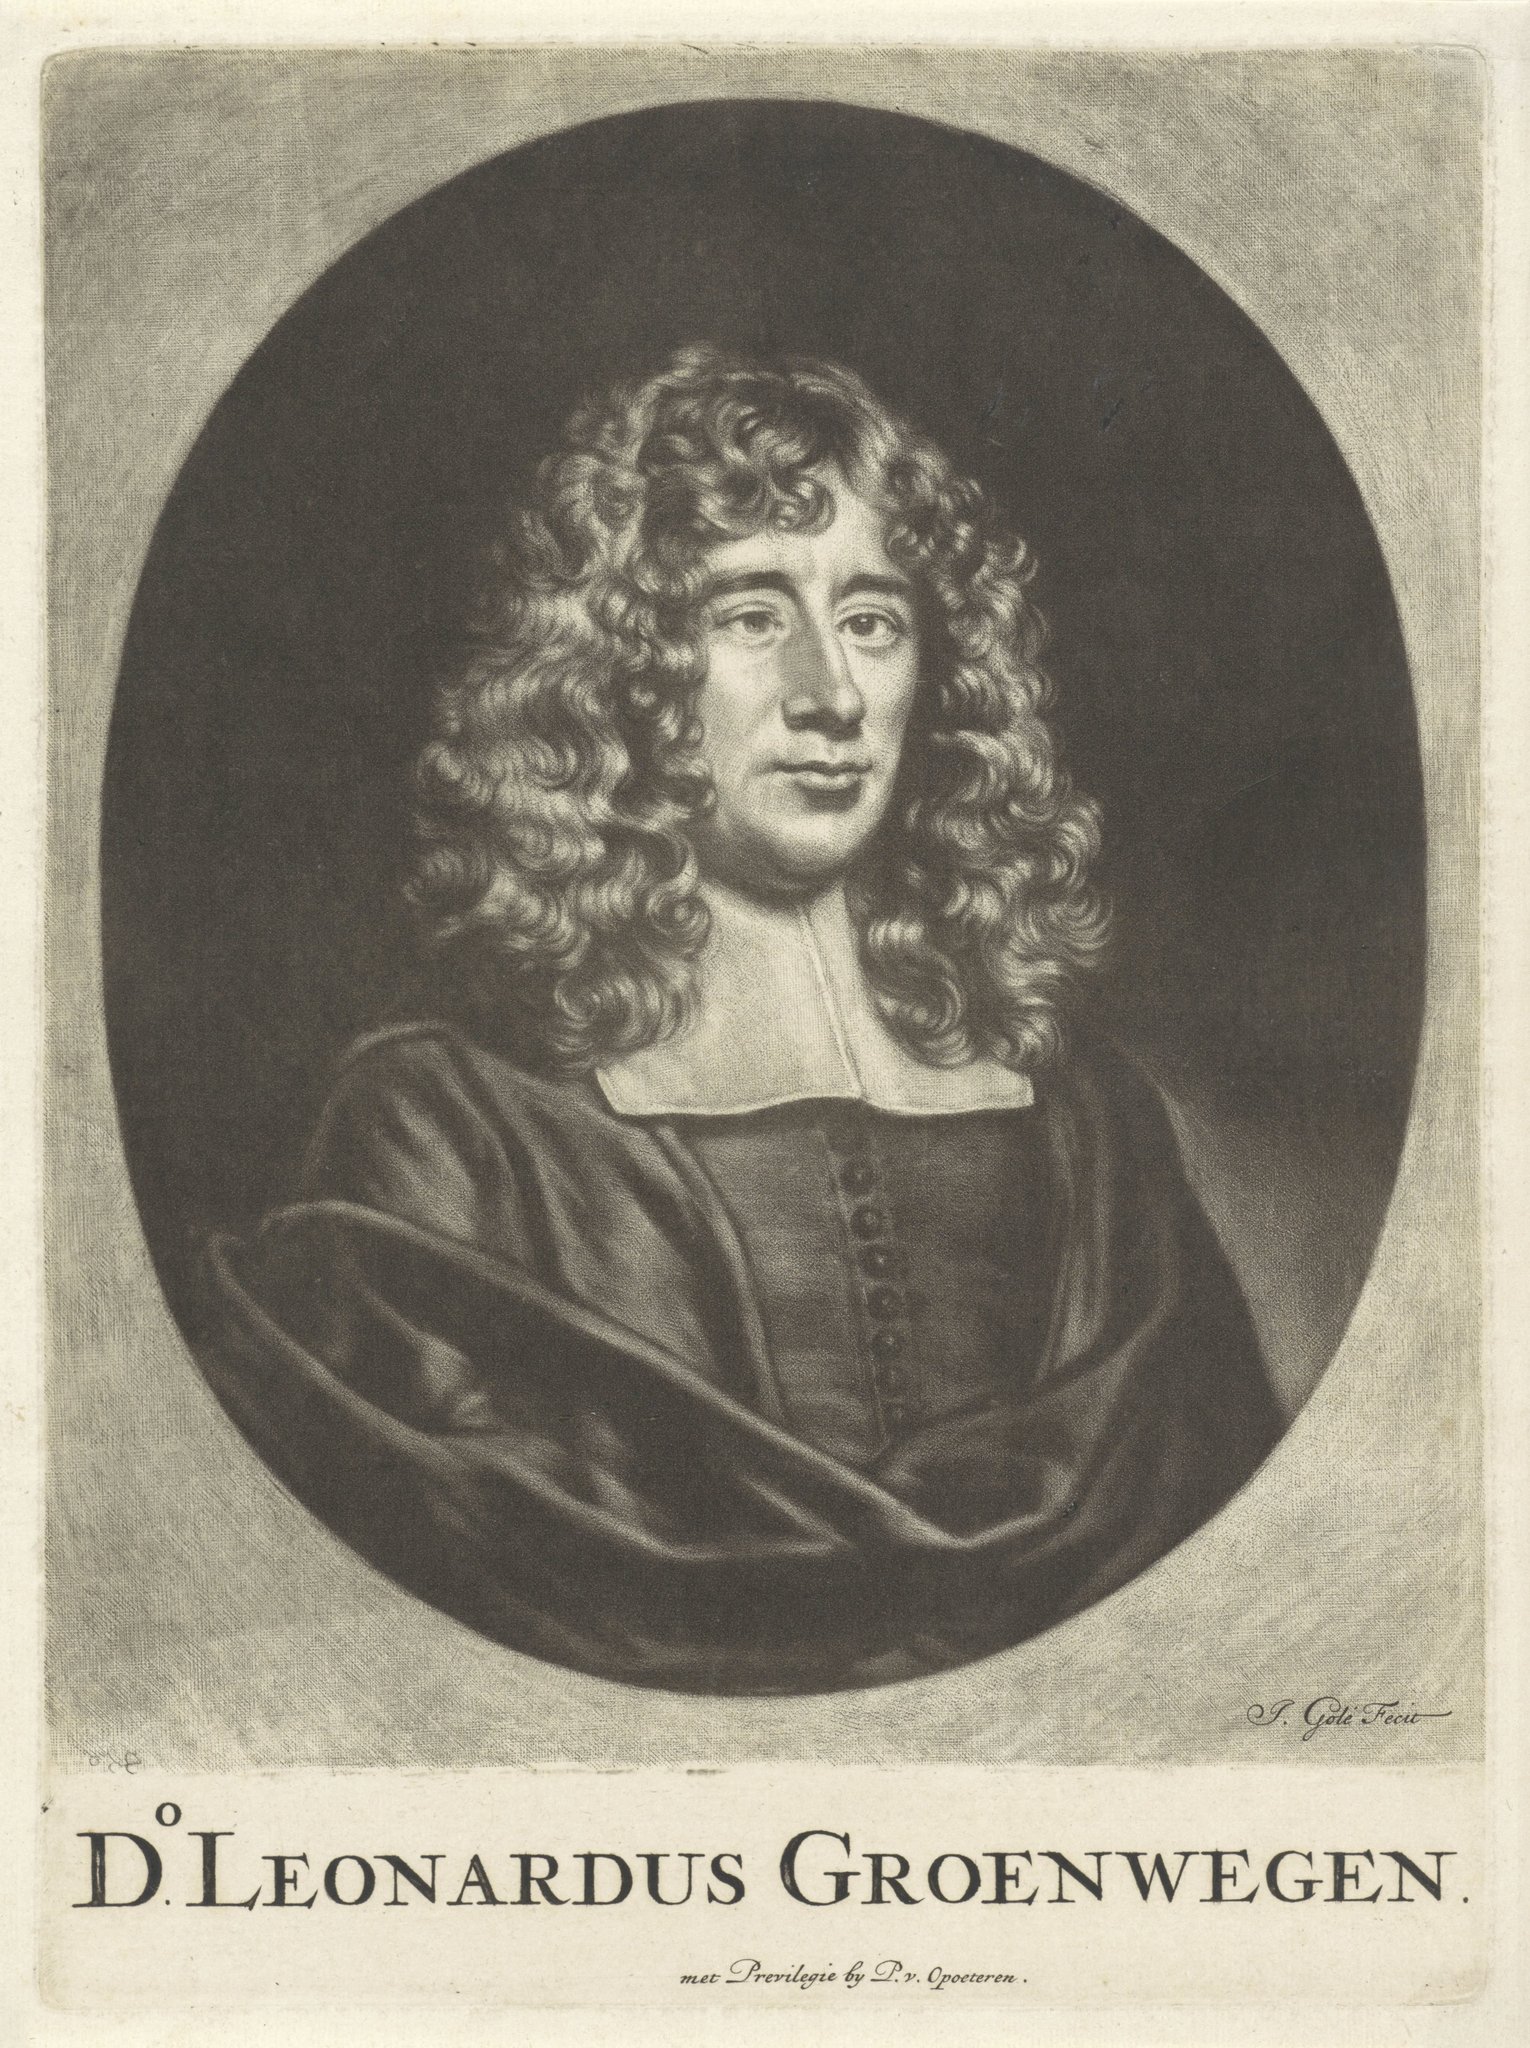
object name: print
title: Portret van Leonardus Groenewegen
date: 1675-1699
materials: paper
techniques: engraving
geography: amsterdam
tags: predikant, leonardus groenewegen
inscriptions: collector's mark: Lugt 2228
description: Leonardus Groenewegen, predikant te Amsterdam.